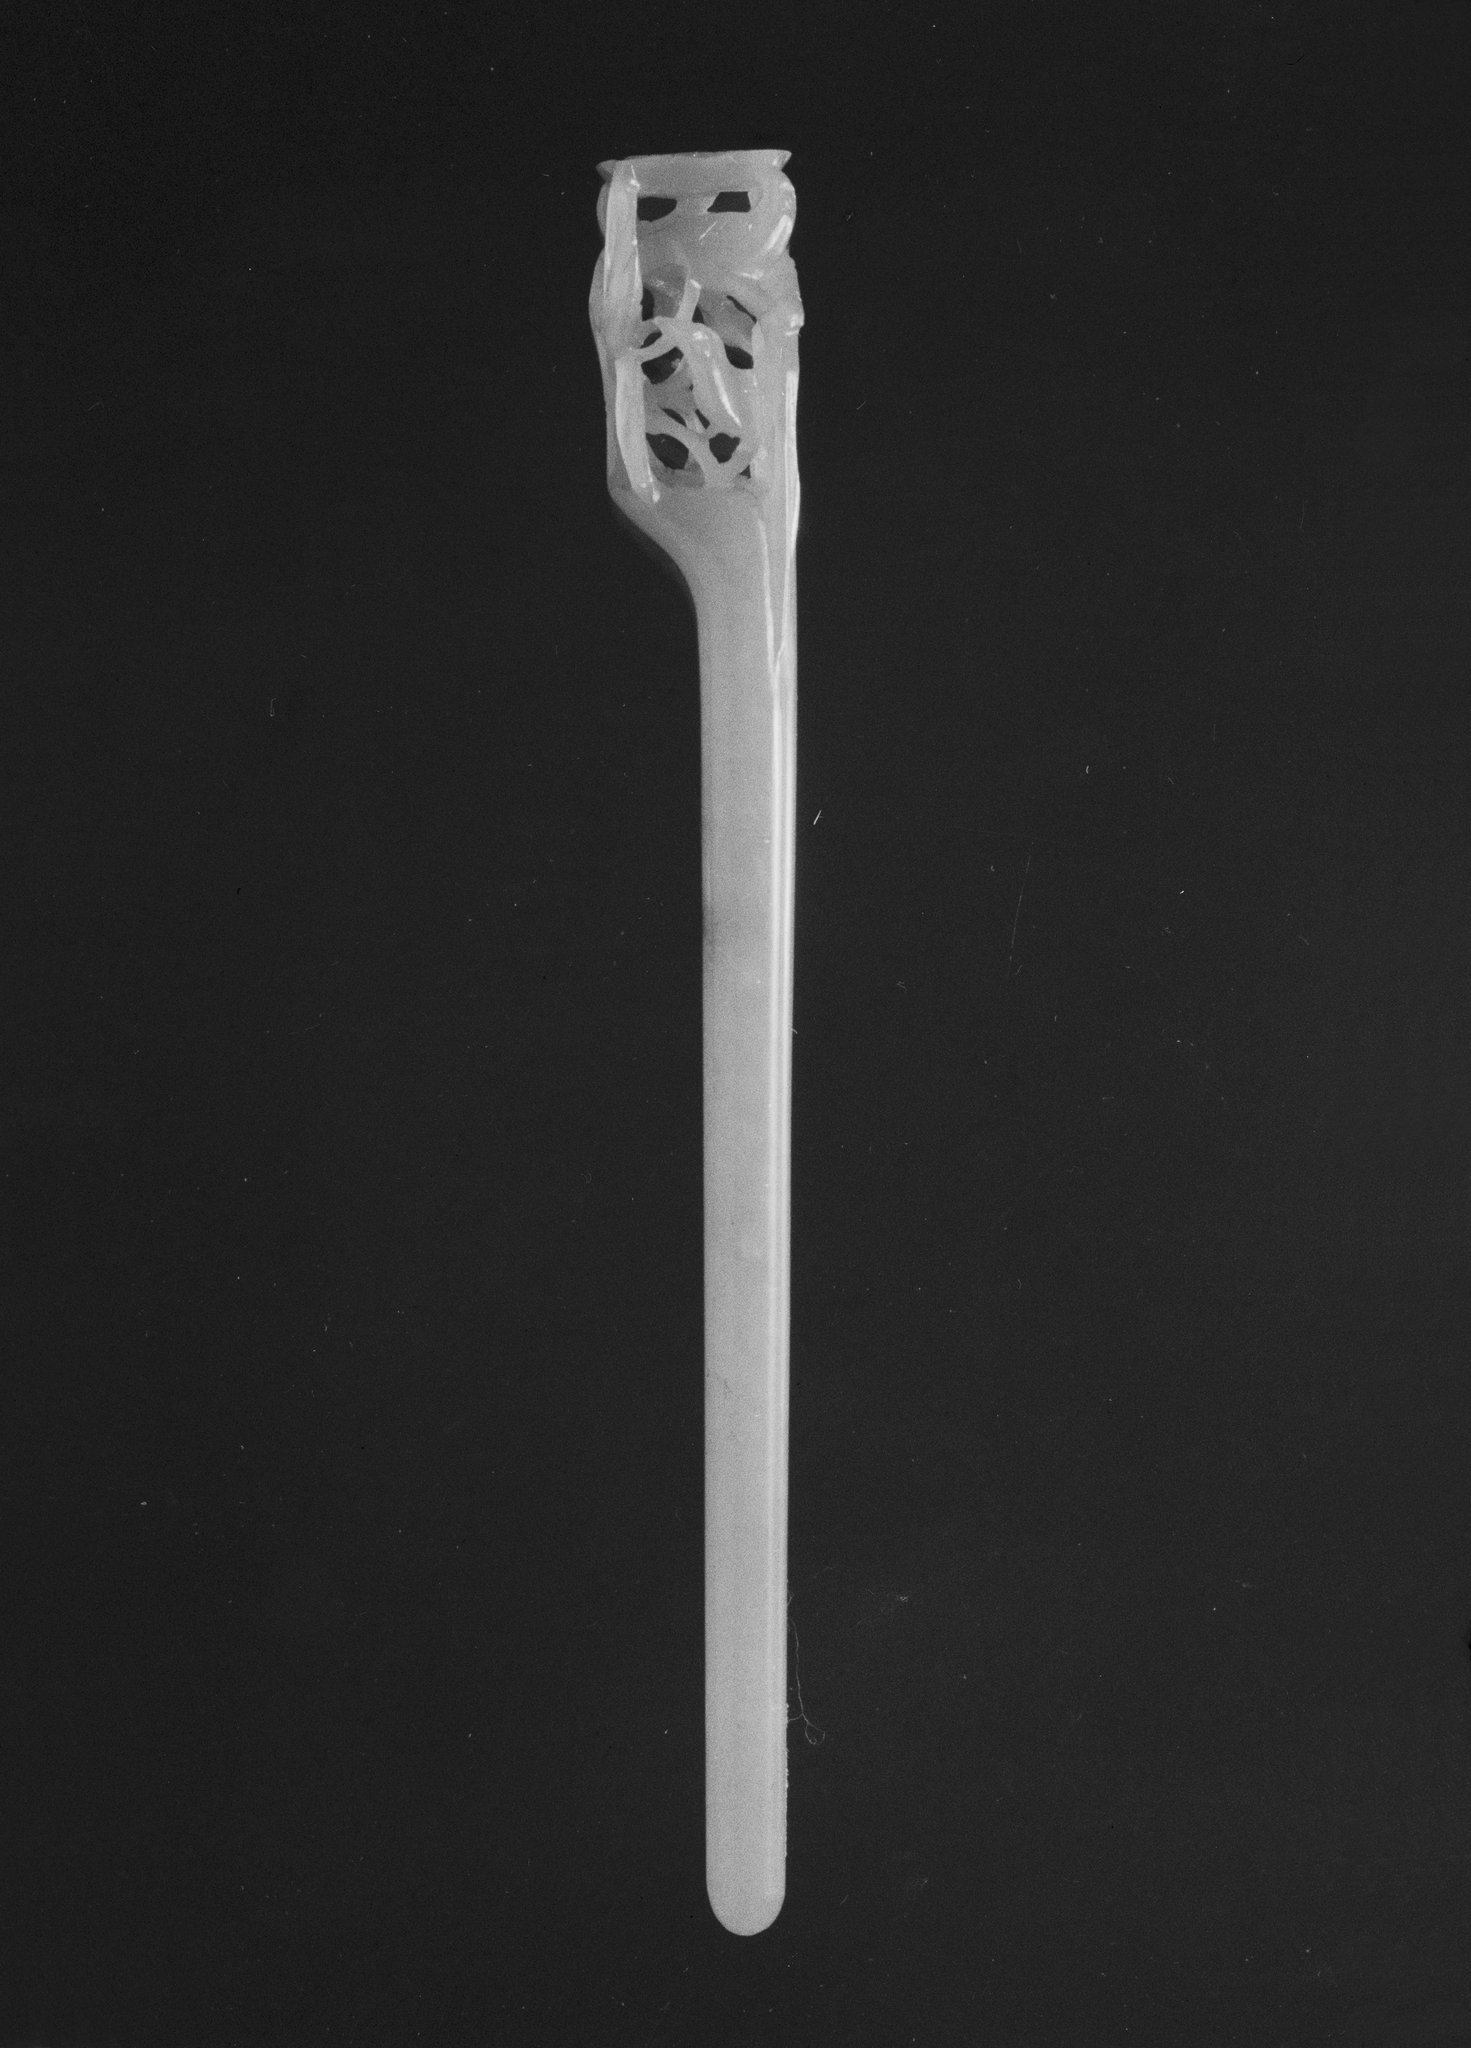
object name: hairpin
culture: chinese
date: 1401-1600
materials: jade